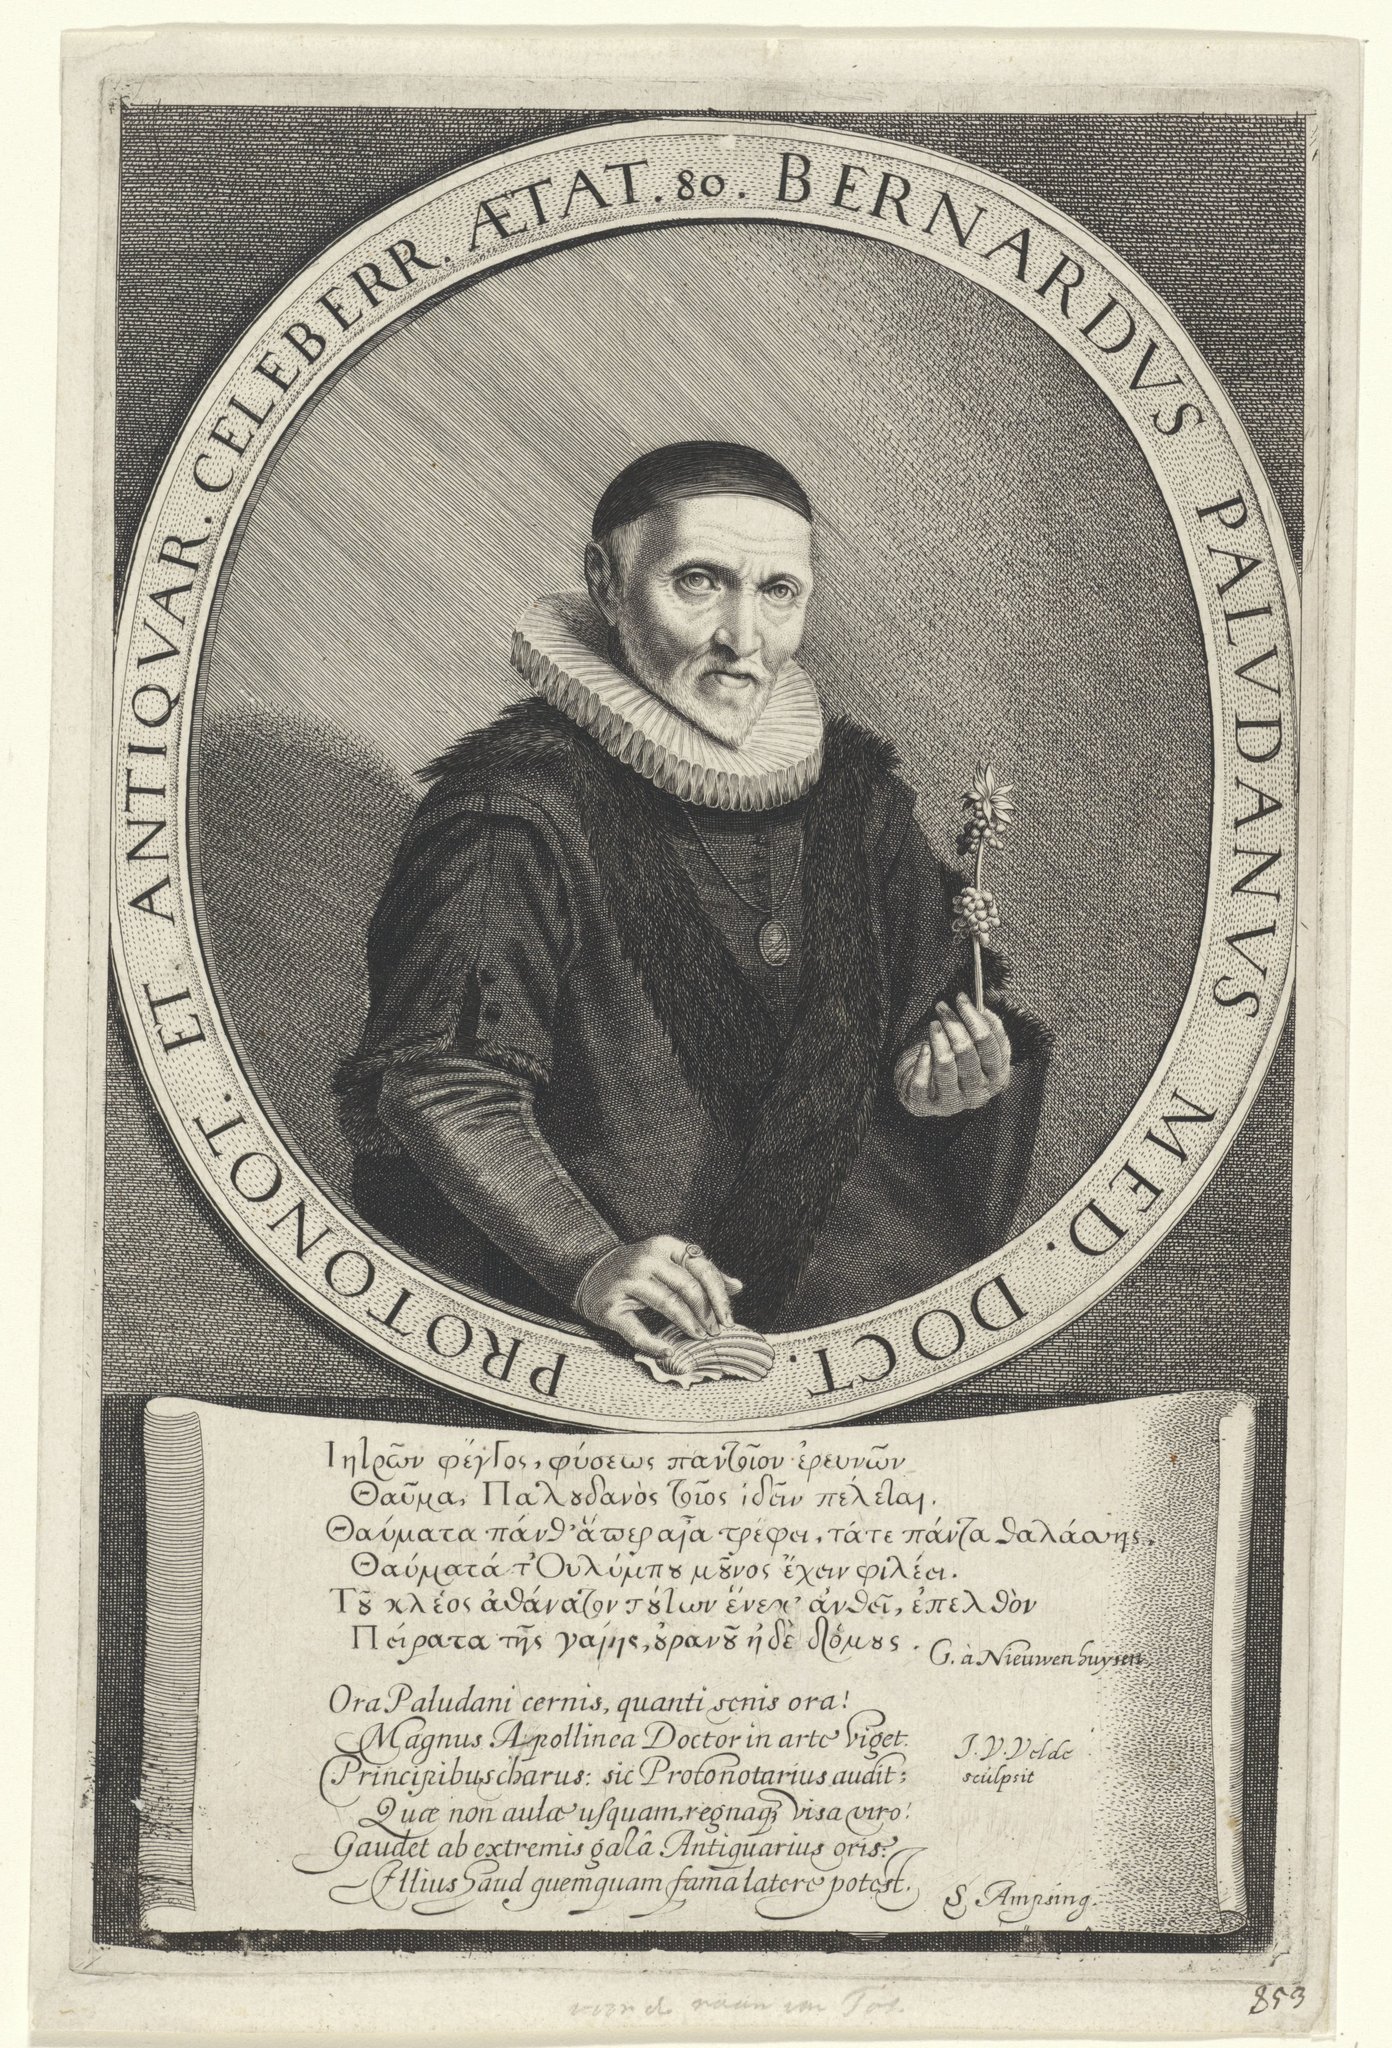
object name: print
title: Portret van Bernardus Paludanus, op 80-jarige leeftijd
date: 1629-1641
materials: paper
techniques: engraving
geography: northern netherlands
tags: enkhuizen, historical persons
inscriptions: collector's mark: Lugt 240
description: Bernard Paludanus, medicus en verzamelaar, op 80-jarige leeftijd. In zijn hand een tak en onder zijn andere hand een sint-jakobsschelp.